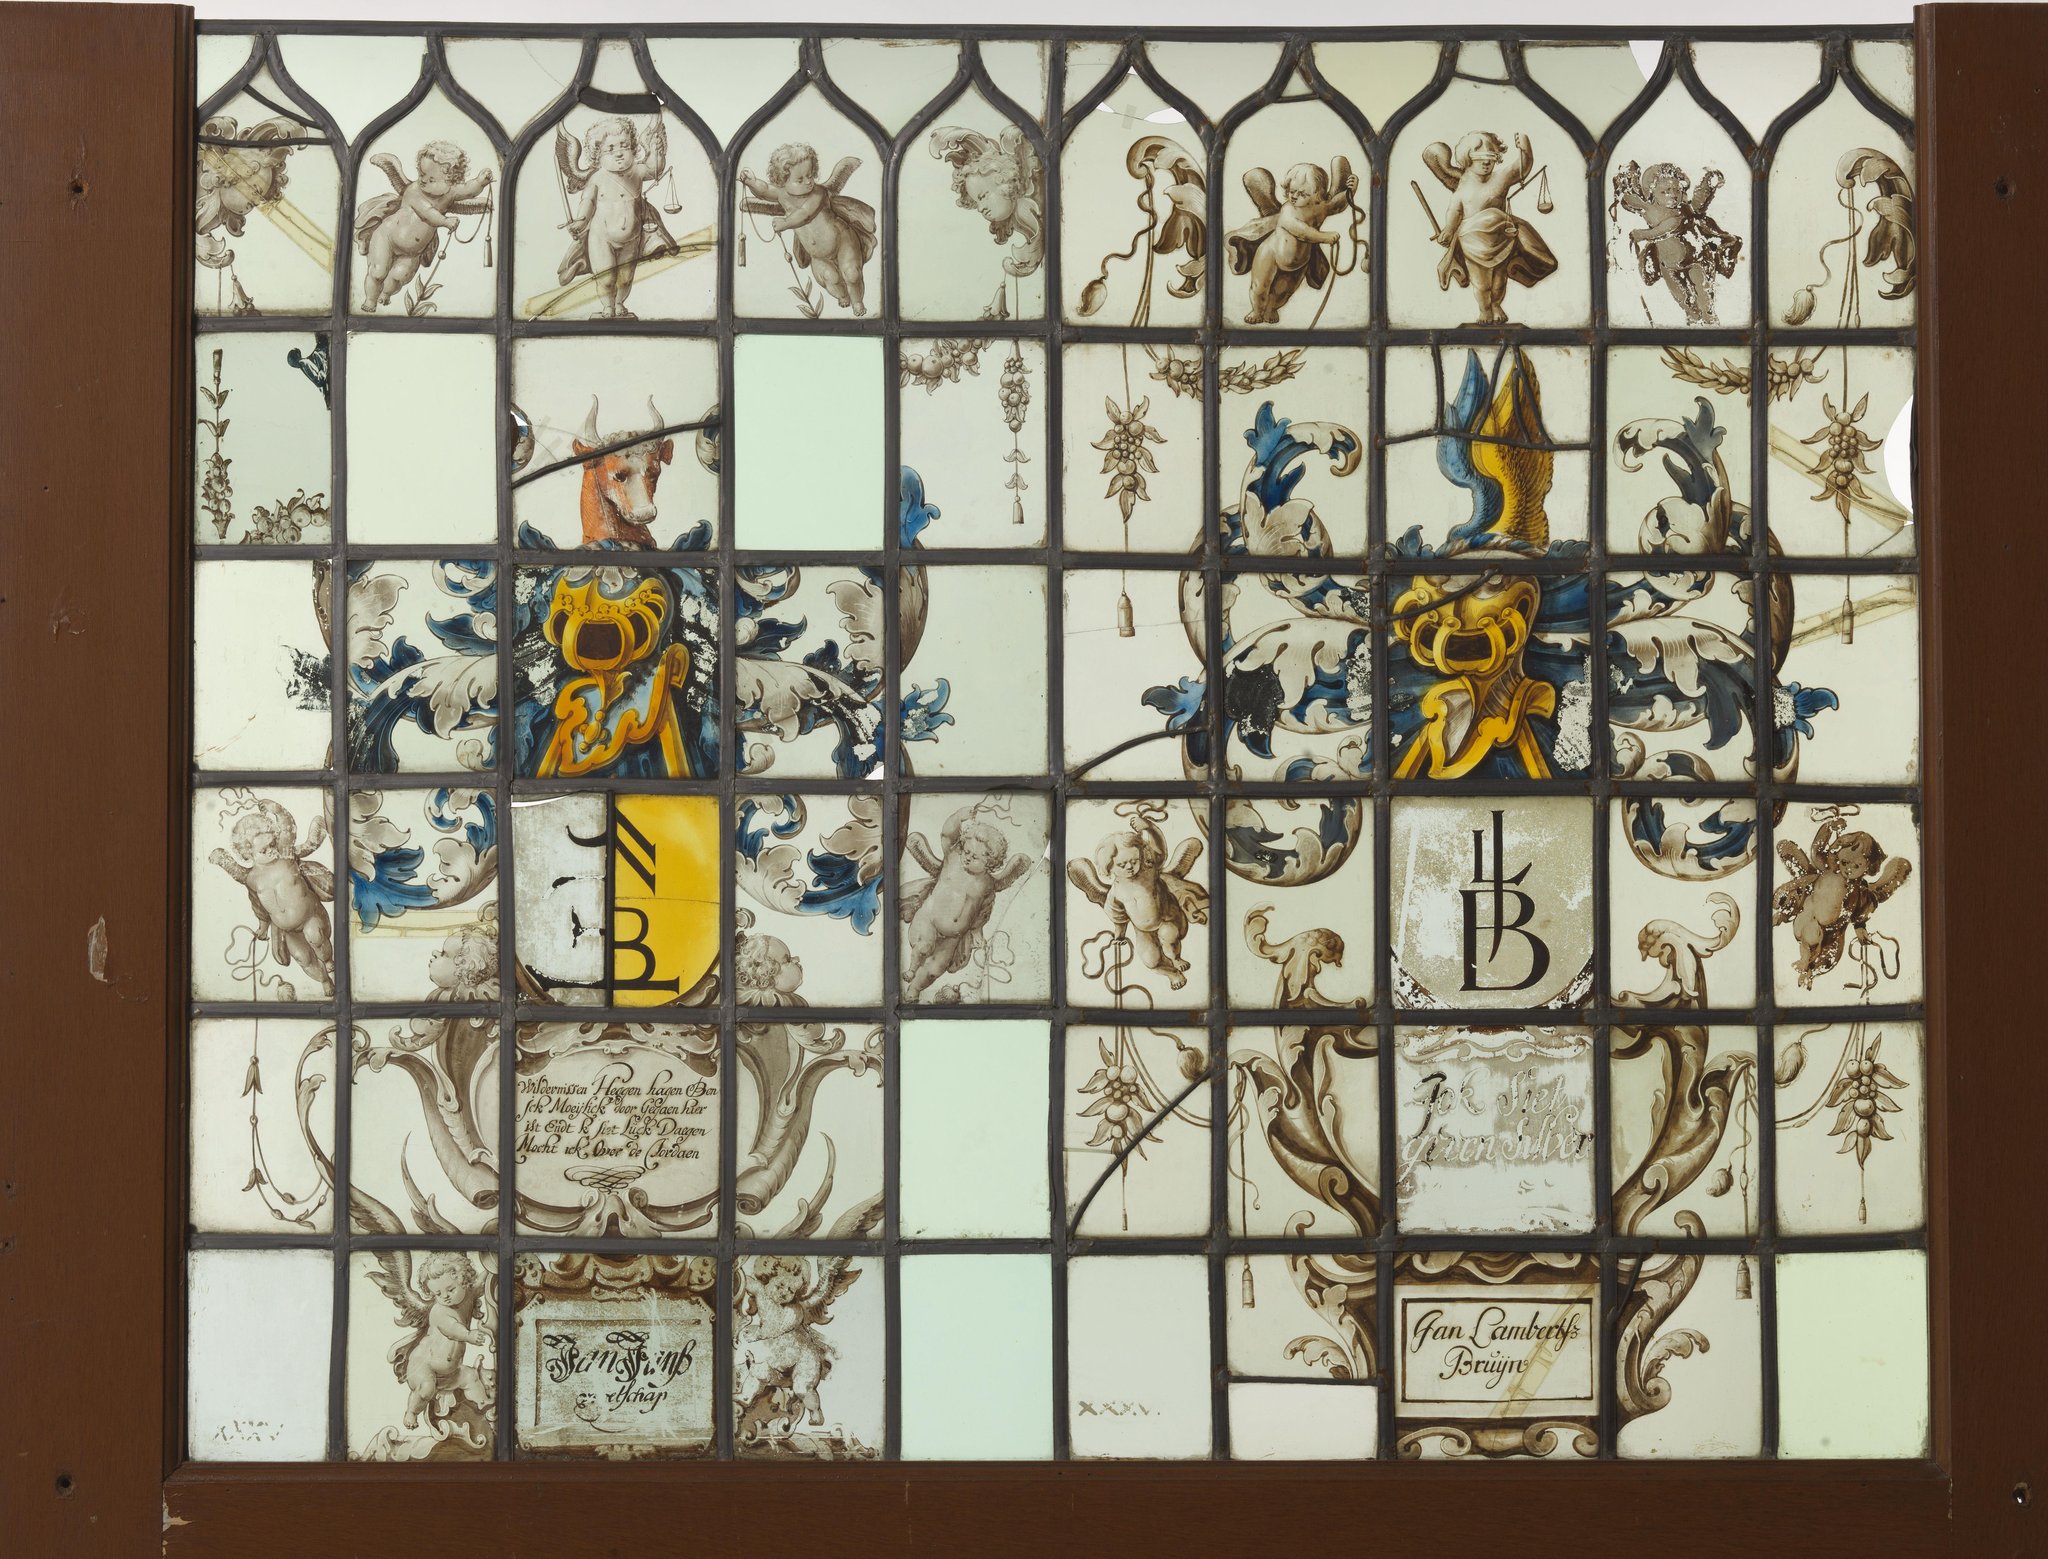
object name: wapenruit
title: Ruit met twee cartouches en een wapenschild met als helmteken twee vleugels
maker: Anonymous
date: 1600-1699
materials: glass, lead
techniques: leading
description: Wapenruit met als helmteken twee vleugels. Daaronder tweemaal een cartouche waarin "Ick Siet geen silver" en "Jan Lambertsz Bruijn".